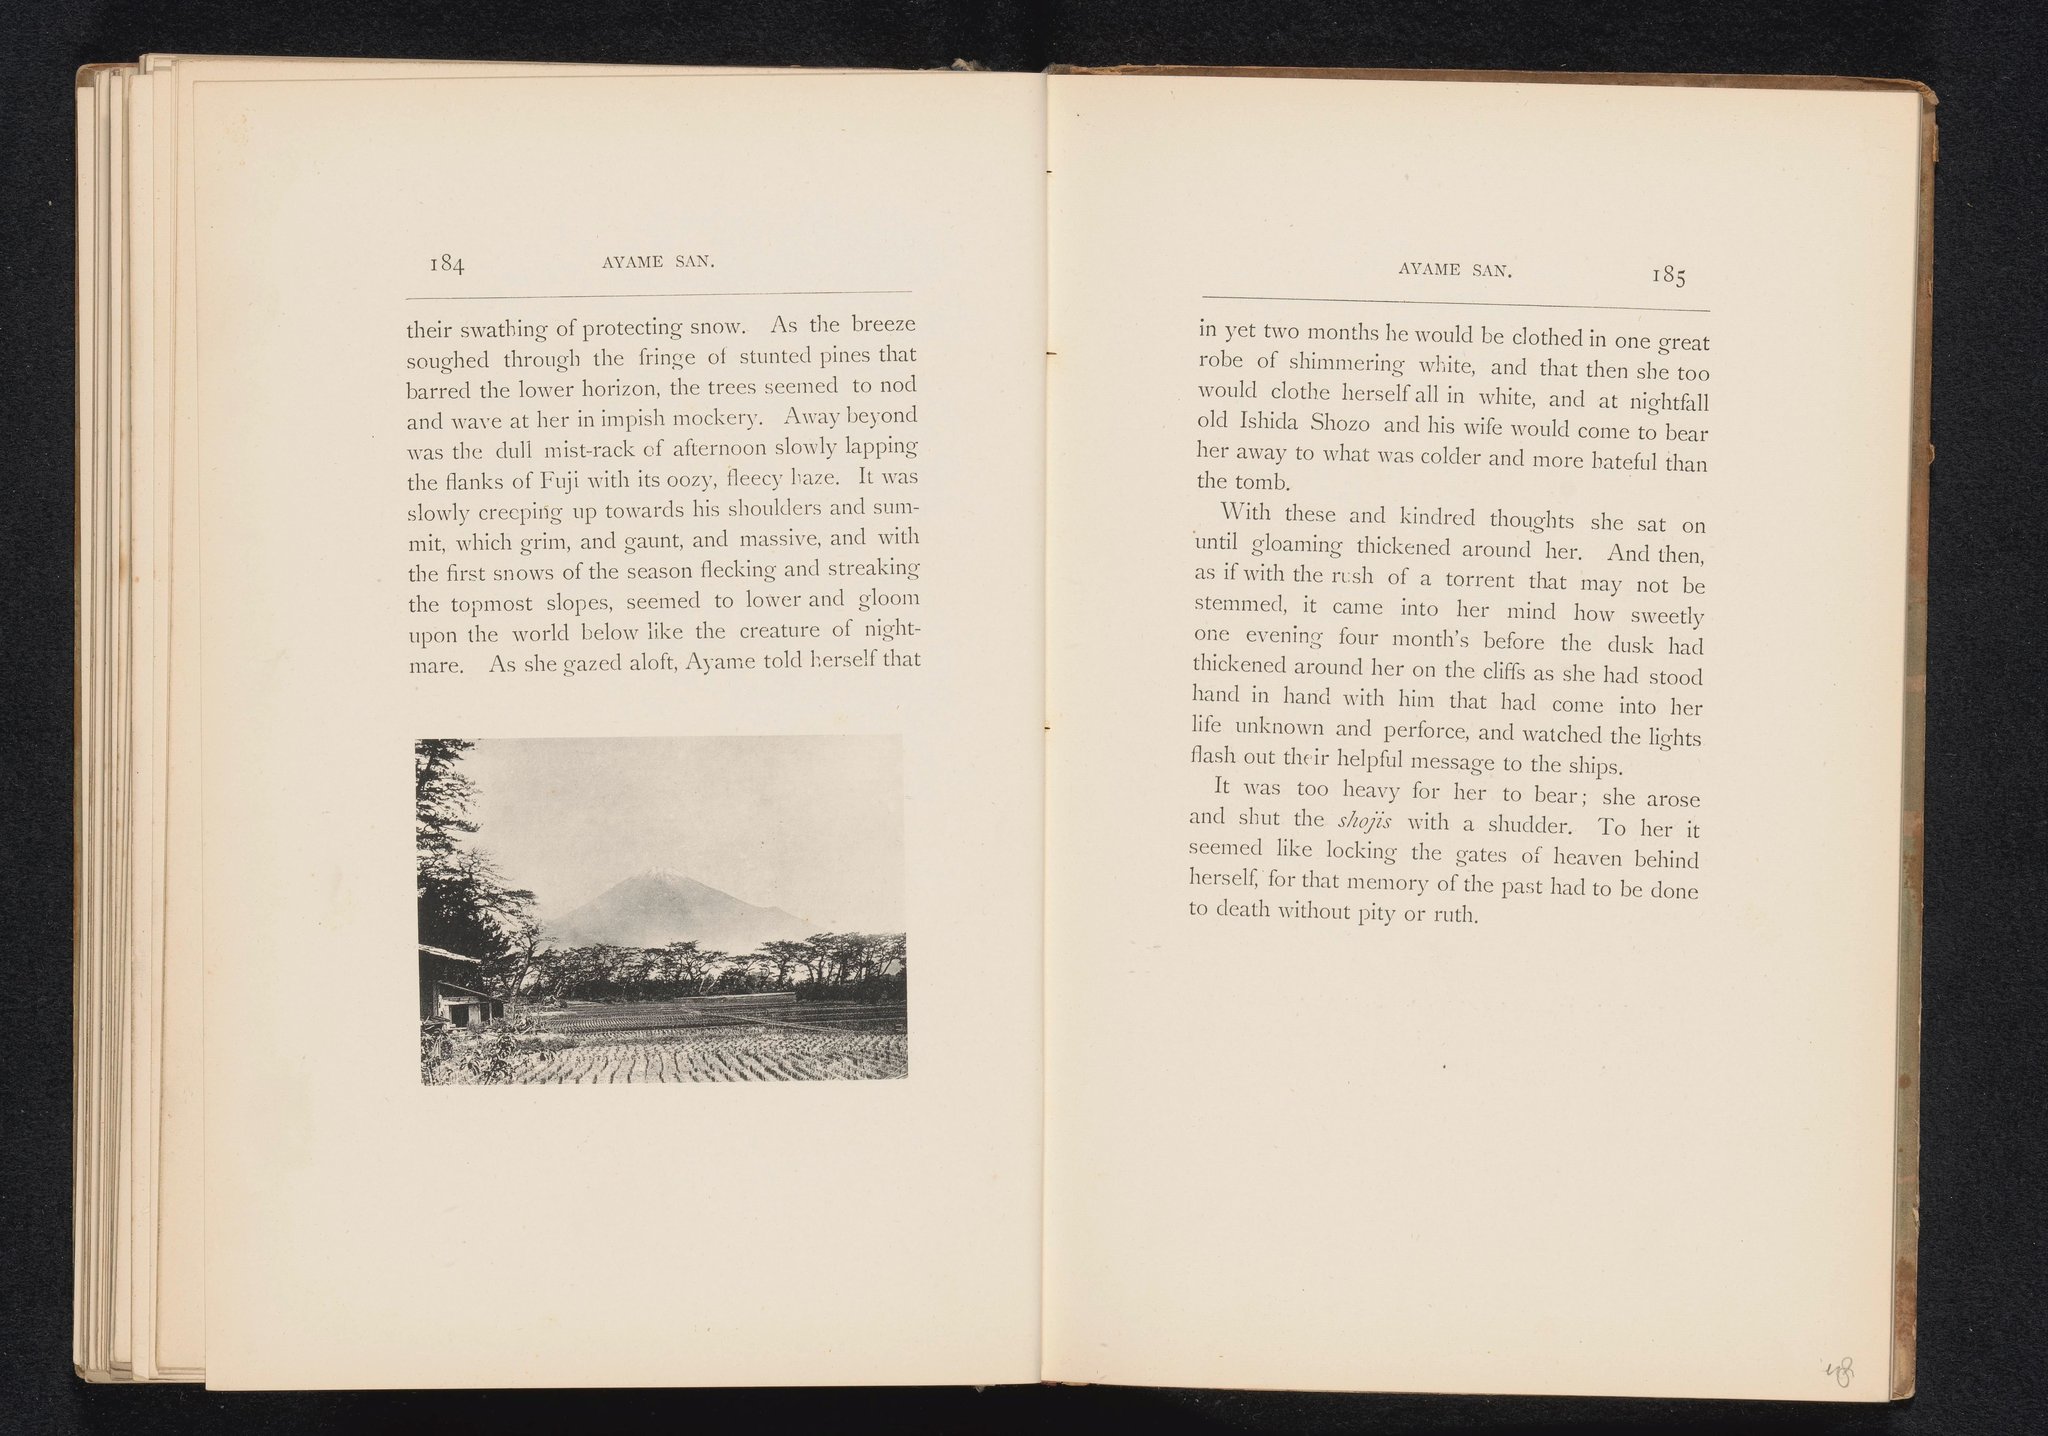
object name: page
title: Gezicht op de berg Fuji te Japan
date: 1882-1892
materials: paper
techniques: photograph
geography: japan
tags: extinct volcano